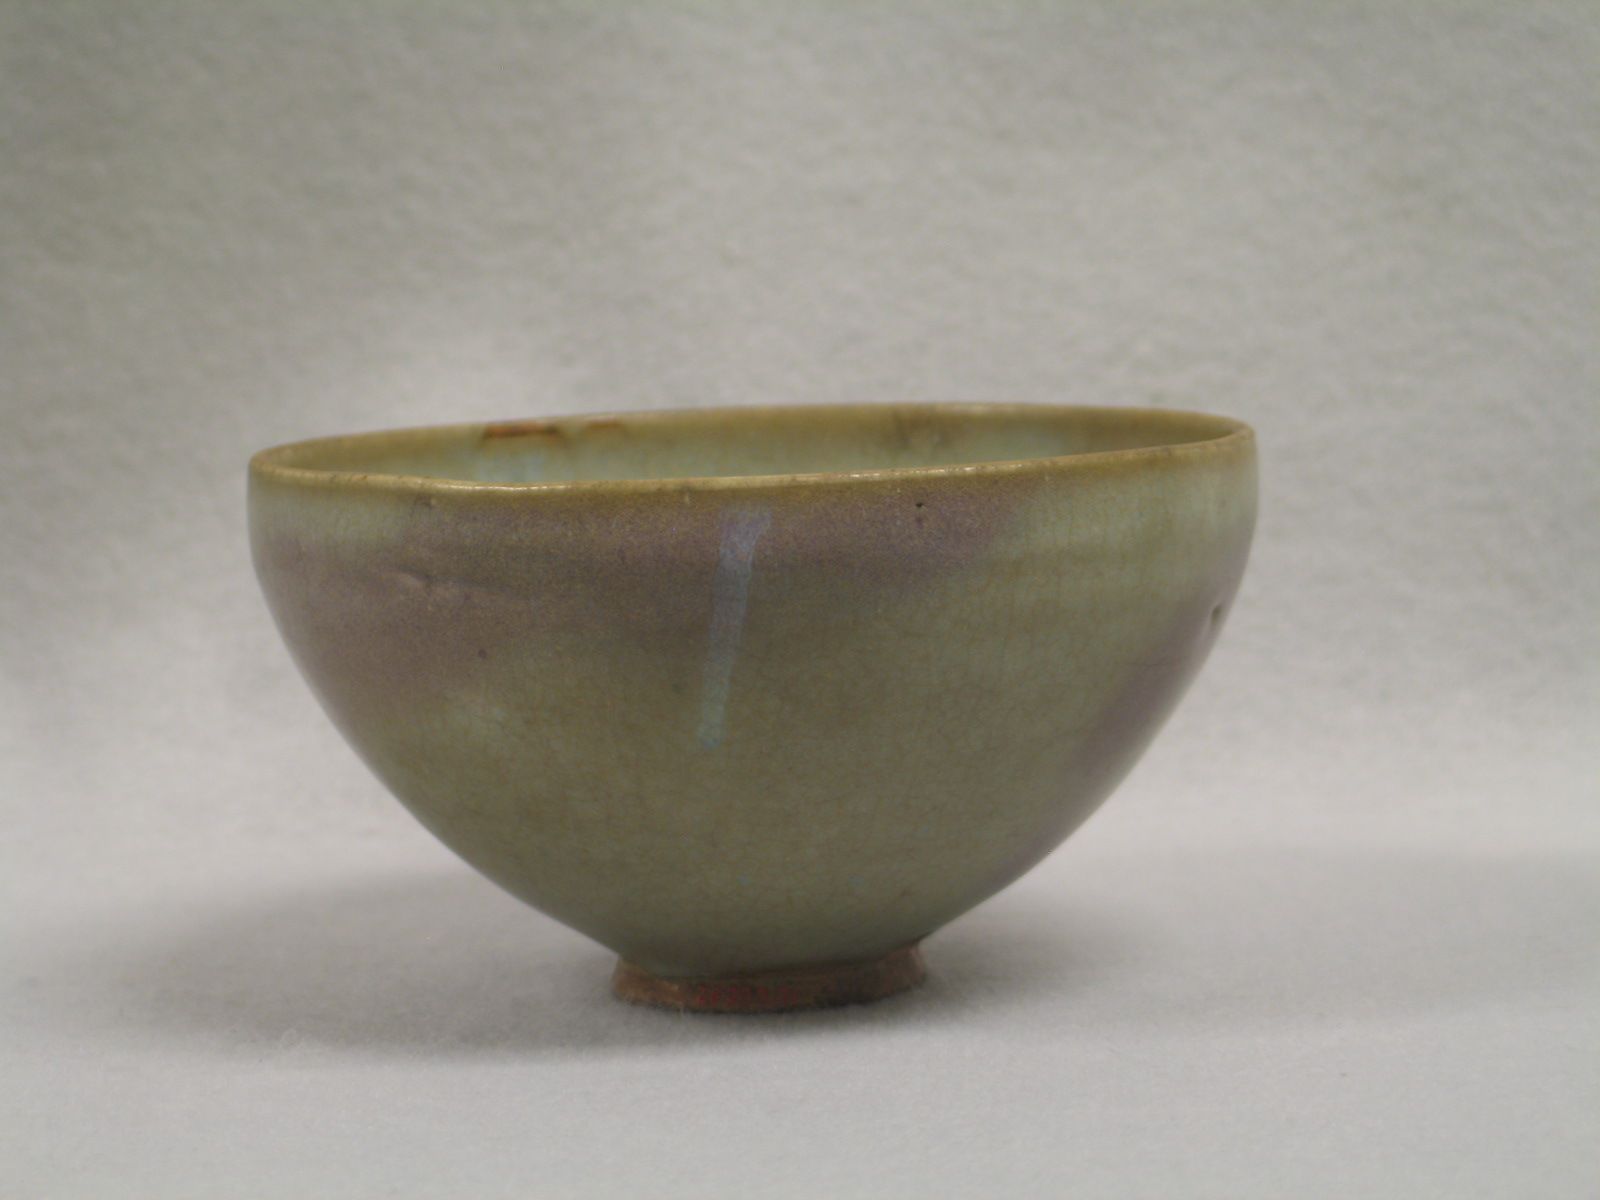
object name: bowl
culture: chinese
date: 1101-1300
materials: glaze, stoneware